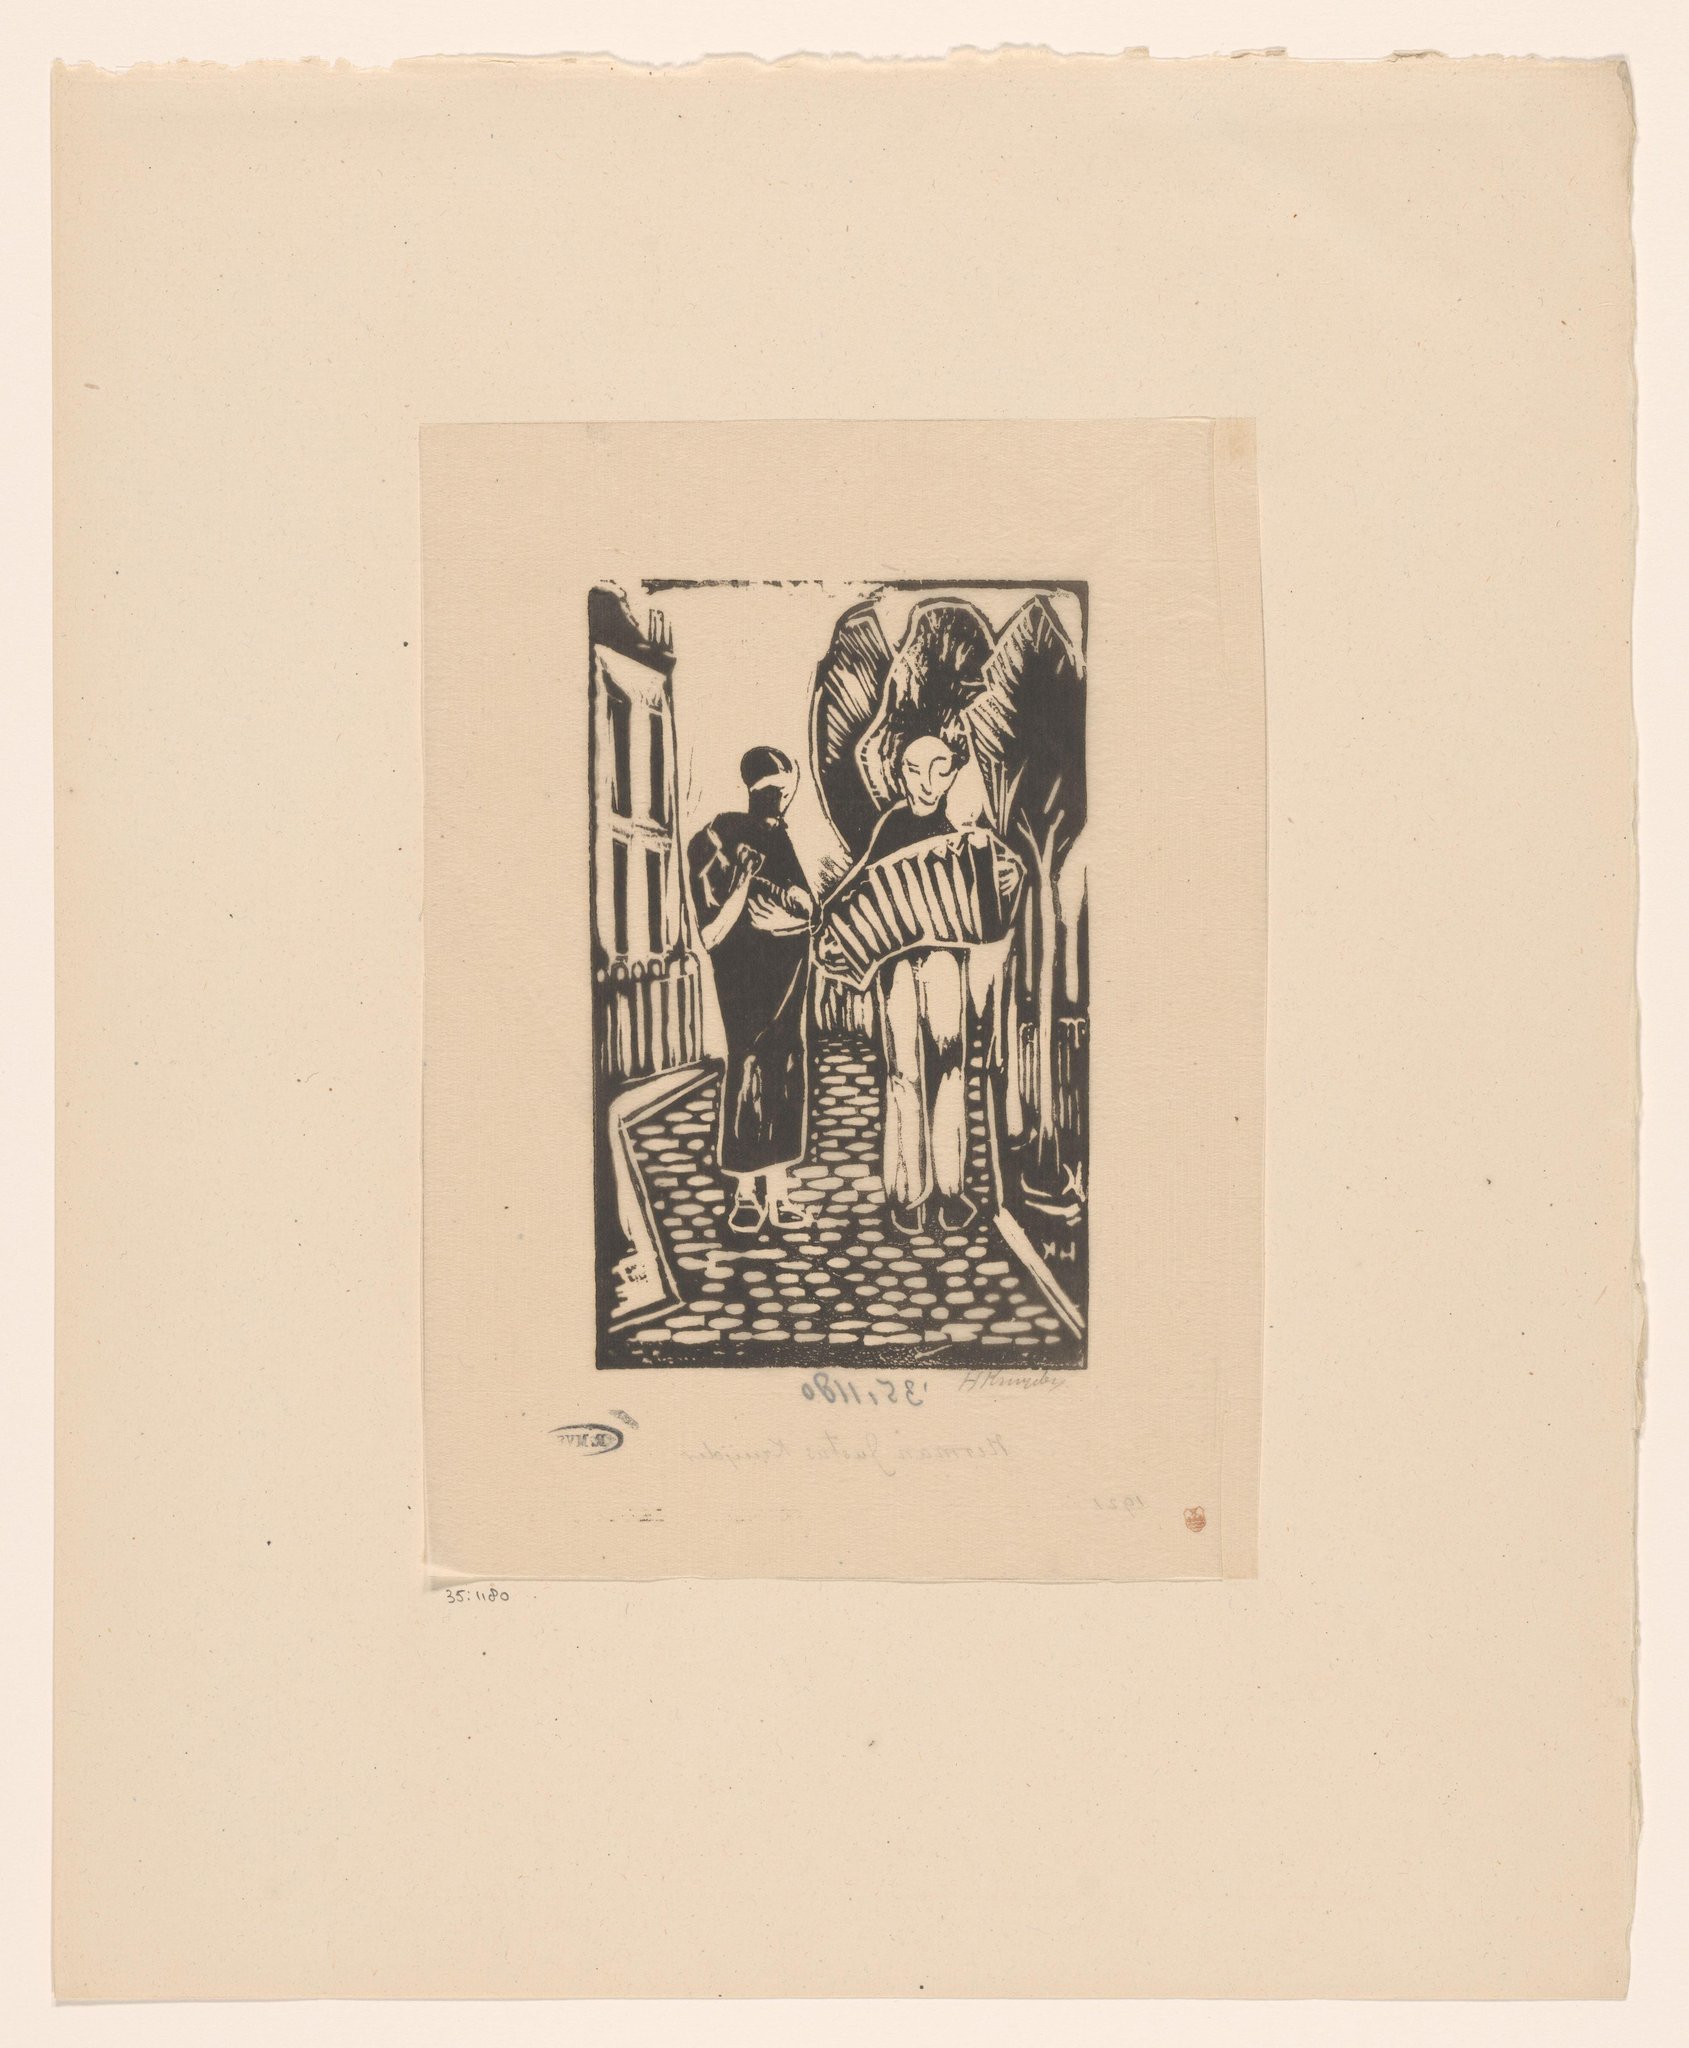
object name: print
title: Straatmuzikanten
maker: herman kruyder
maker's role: draughtsman, print maker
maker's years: 1881-1935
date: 1891-1935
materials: paper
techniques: linocut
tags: popular music, street music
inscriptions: collector's mark: Lugt 2228, collector's mark: Lugt 2760